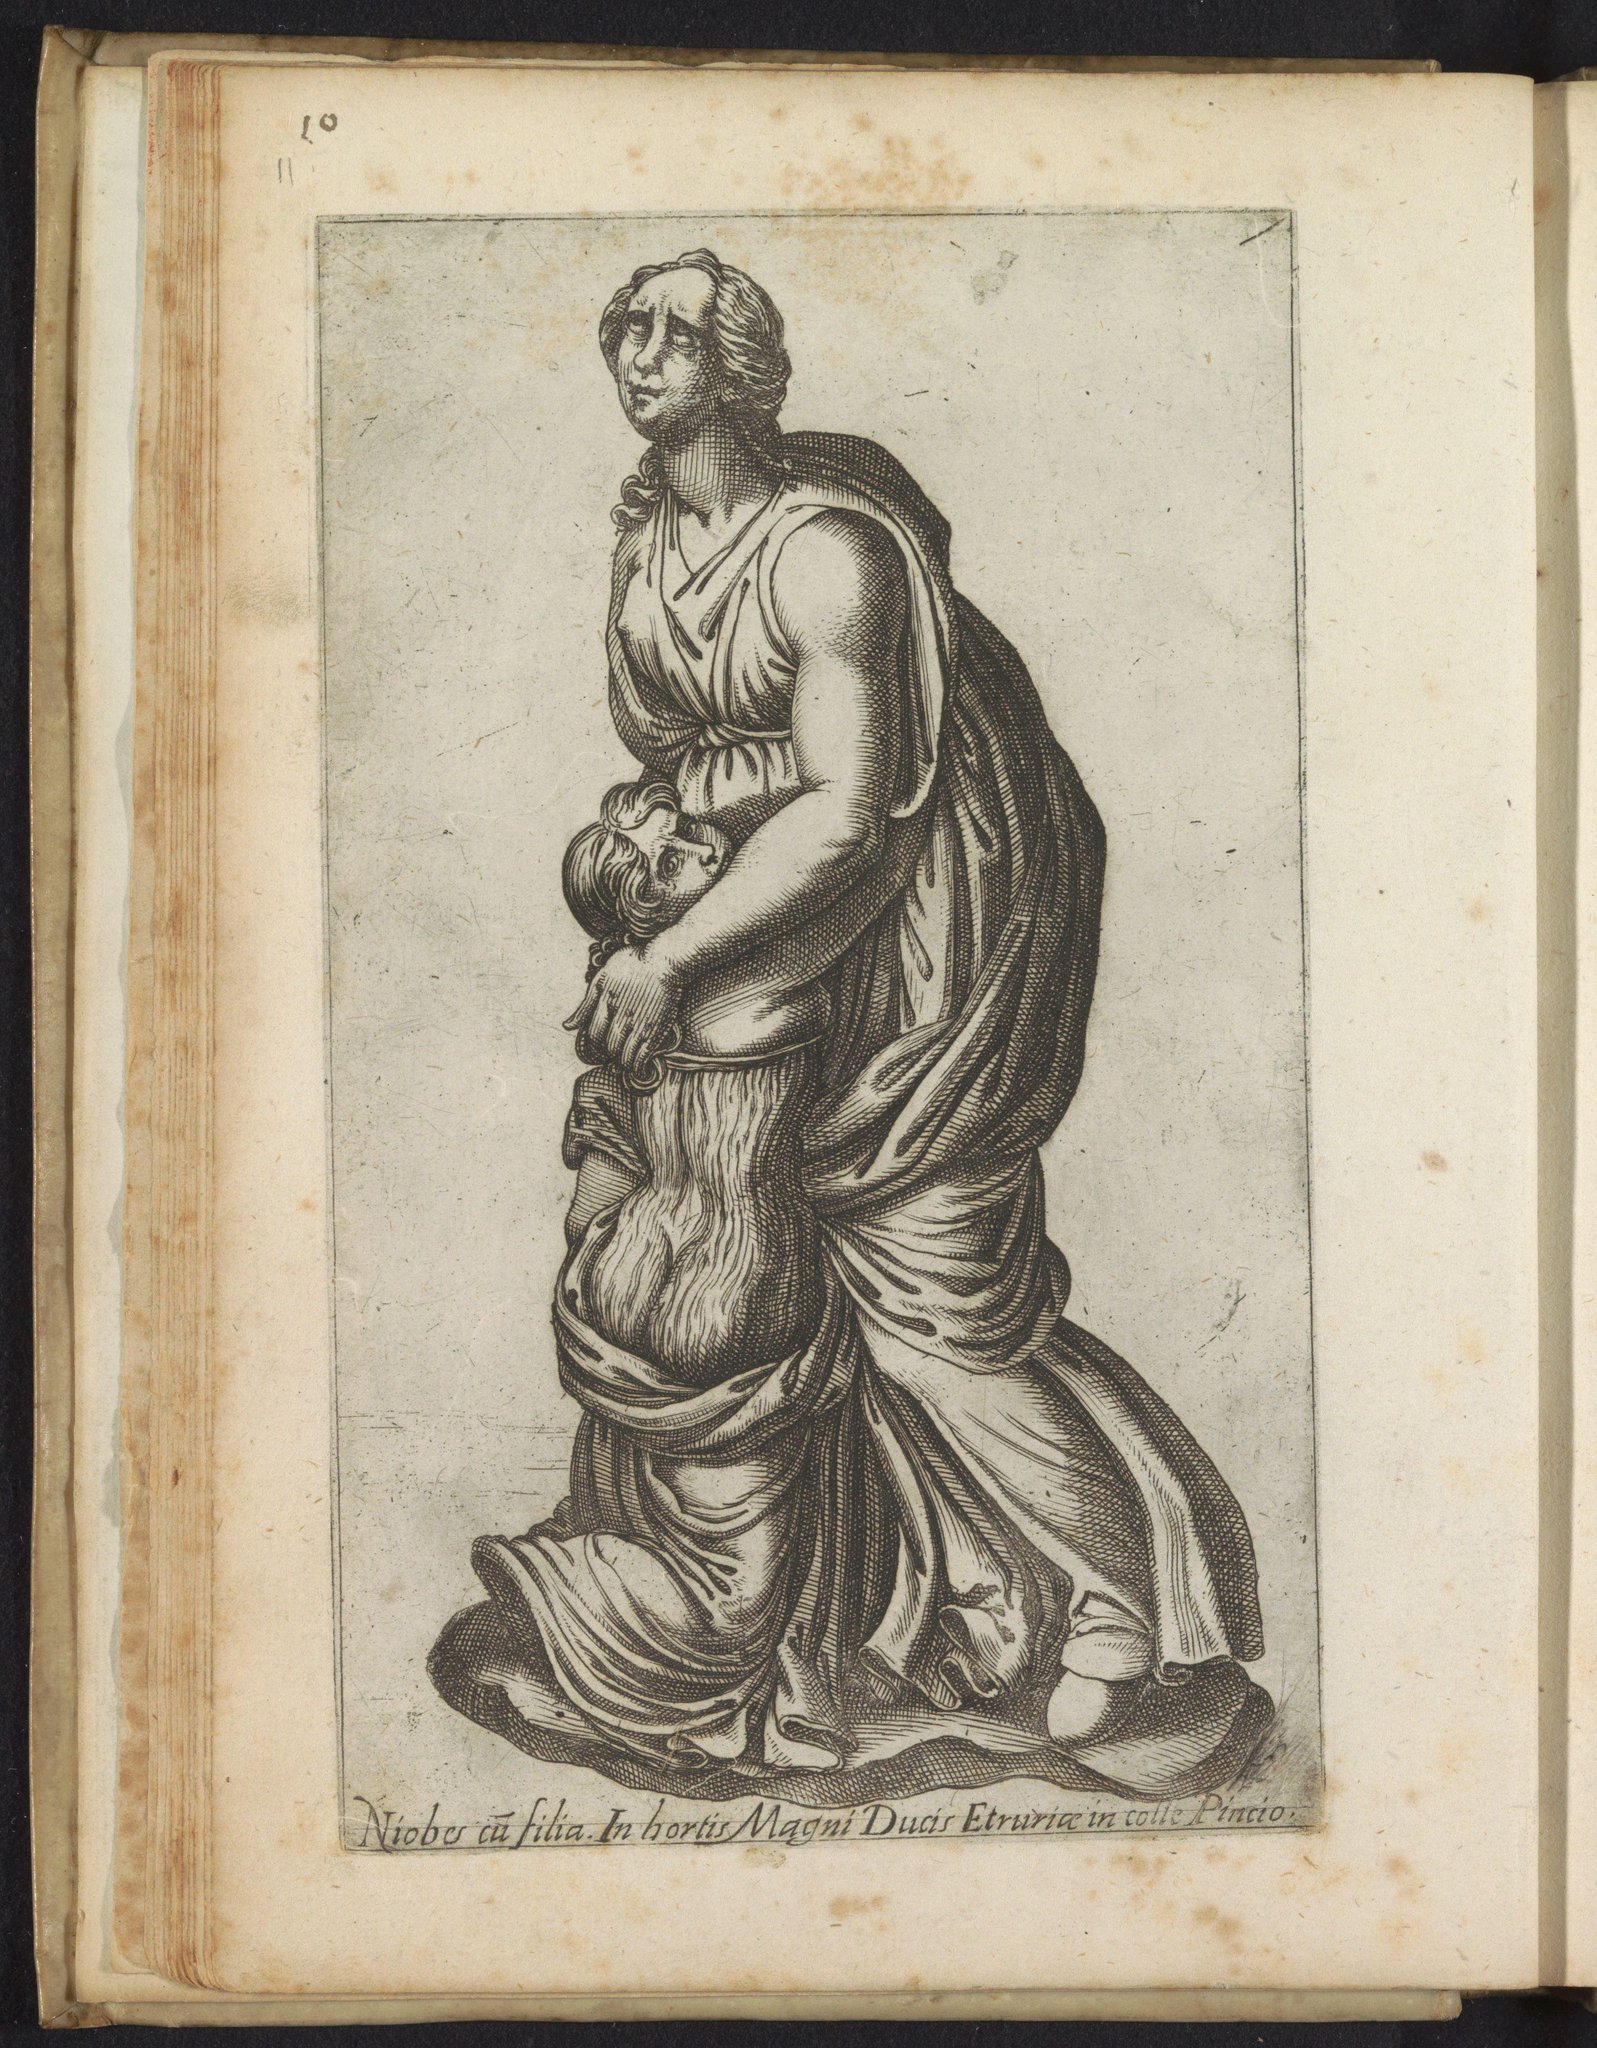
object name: album leaf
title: Niobes cu filia in hortis magni ducis (...)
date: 1584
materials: paper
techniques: engraving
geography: italy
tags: piece of sculpture, reproduction of a piece of sculpture, (story of) niobe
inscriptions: number: ‘10’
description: Deze prent maakt deel uit van een set van 79 prenten (+ titelprent) met voorstellingen van antieke sculpturen in Rome.